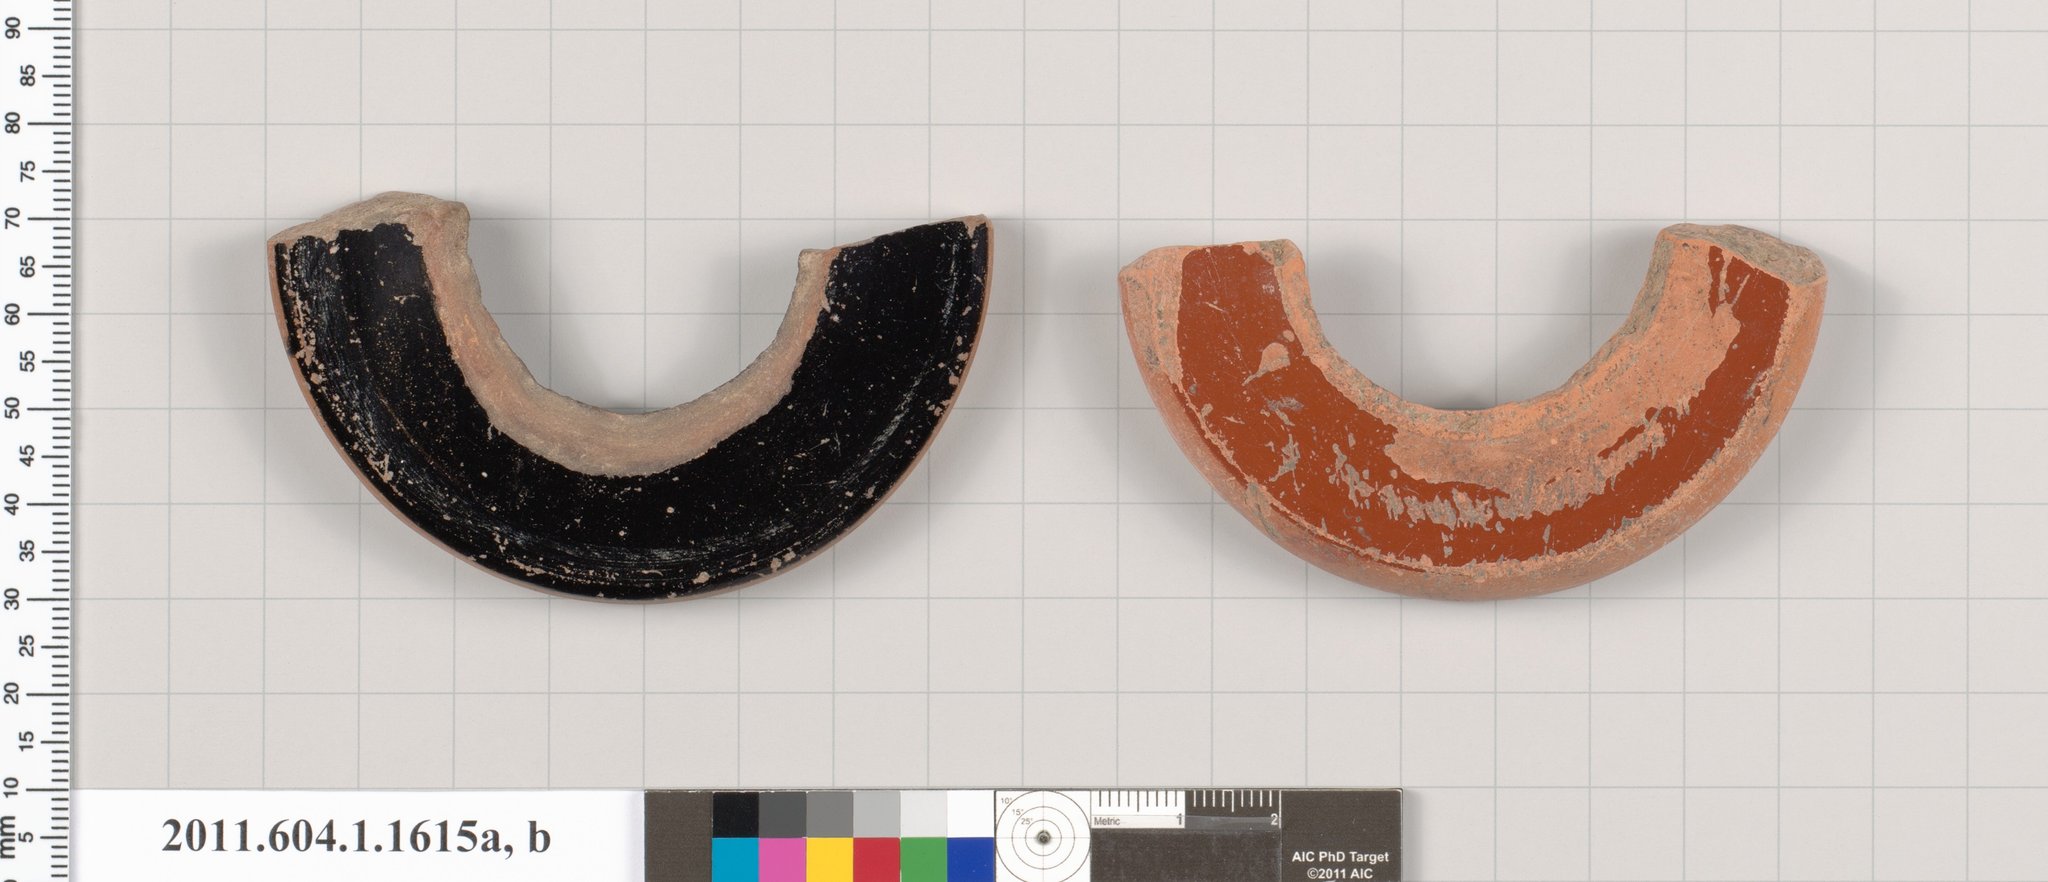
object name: kylix fragment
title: Terracotta fragments of kylikes (drinking cups)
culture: greek, attic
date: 500-401 BCE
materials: terracotta